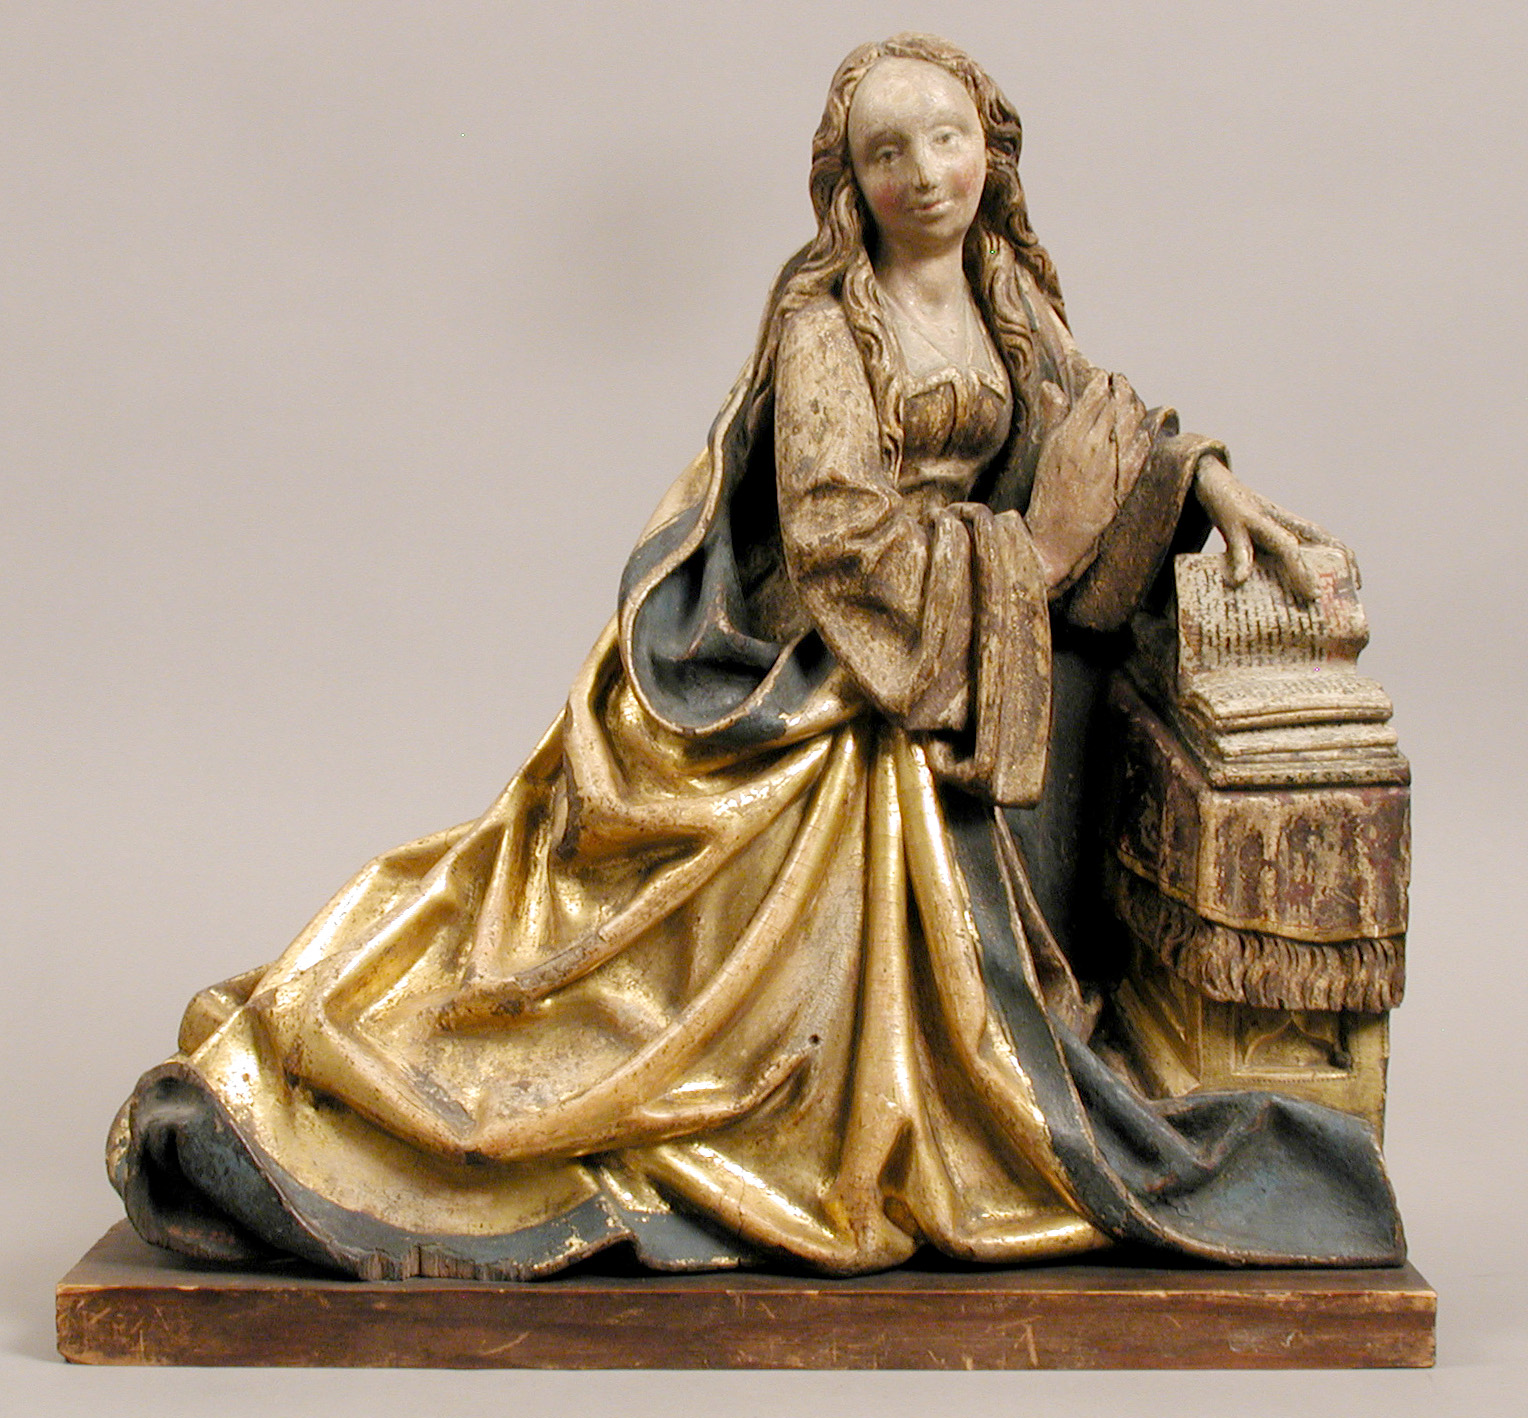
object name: relief statue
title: Virgin of the Annunciation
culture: german, south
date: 1450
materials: wood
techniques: gilding, polychromy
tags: annunciation